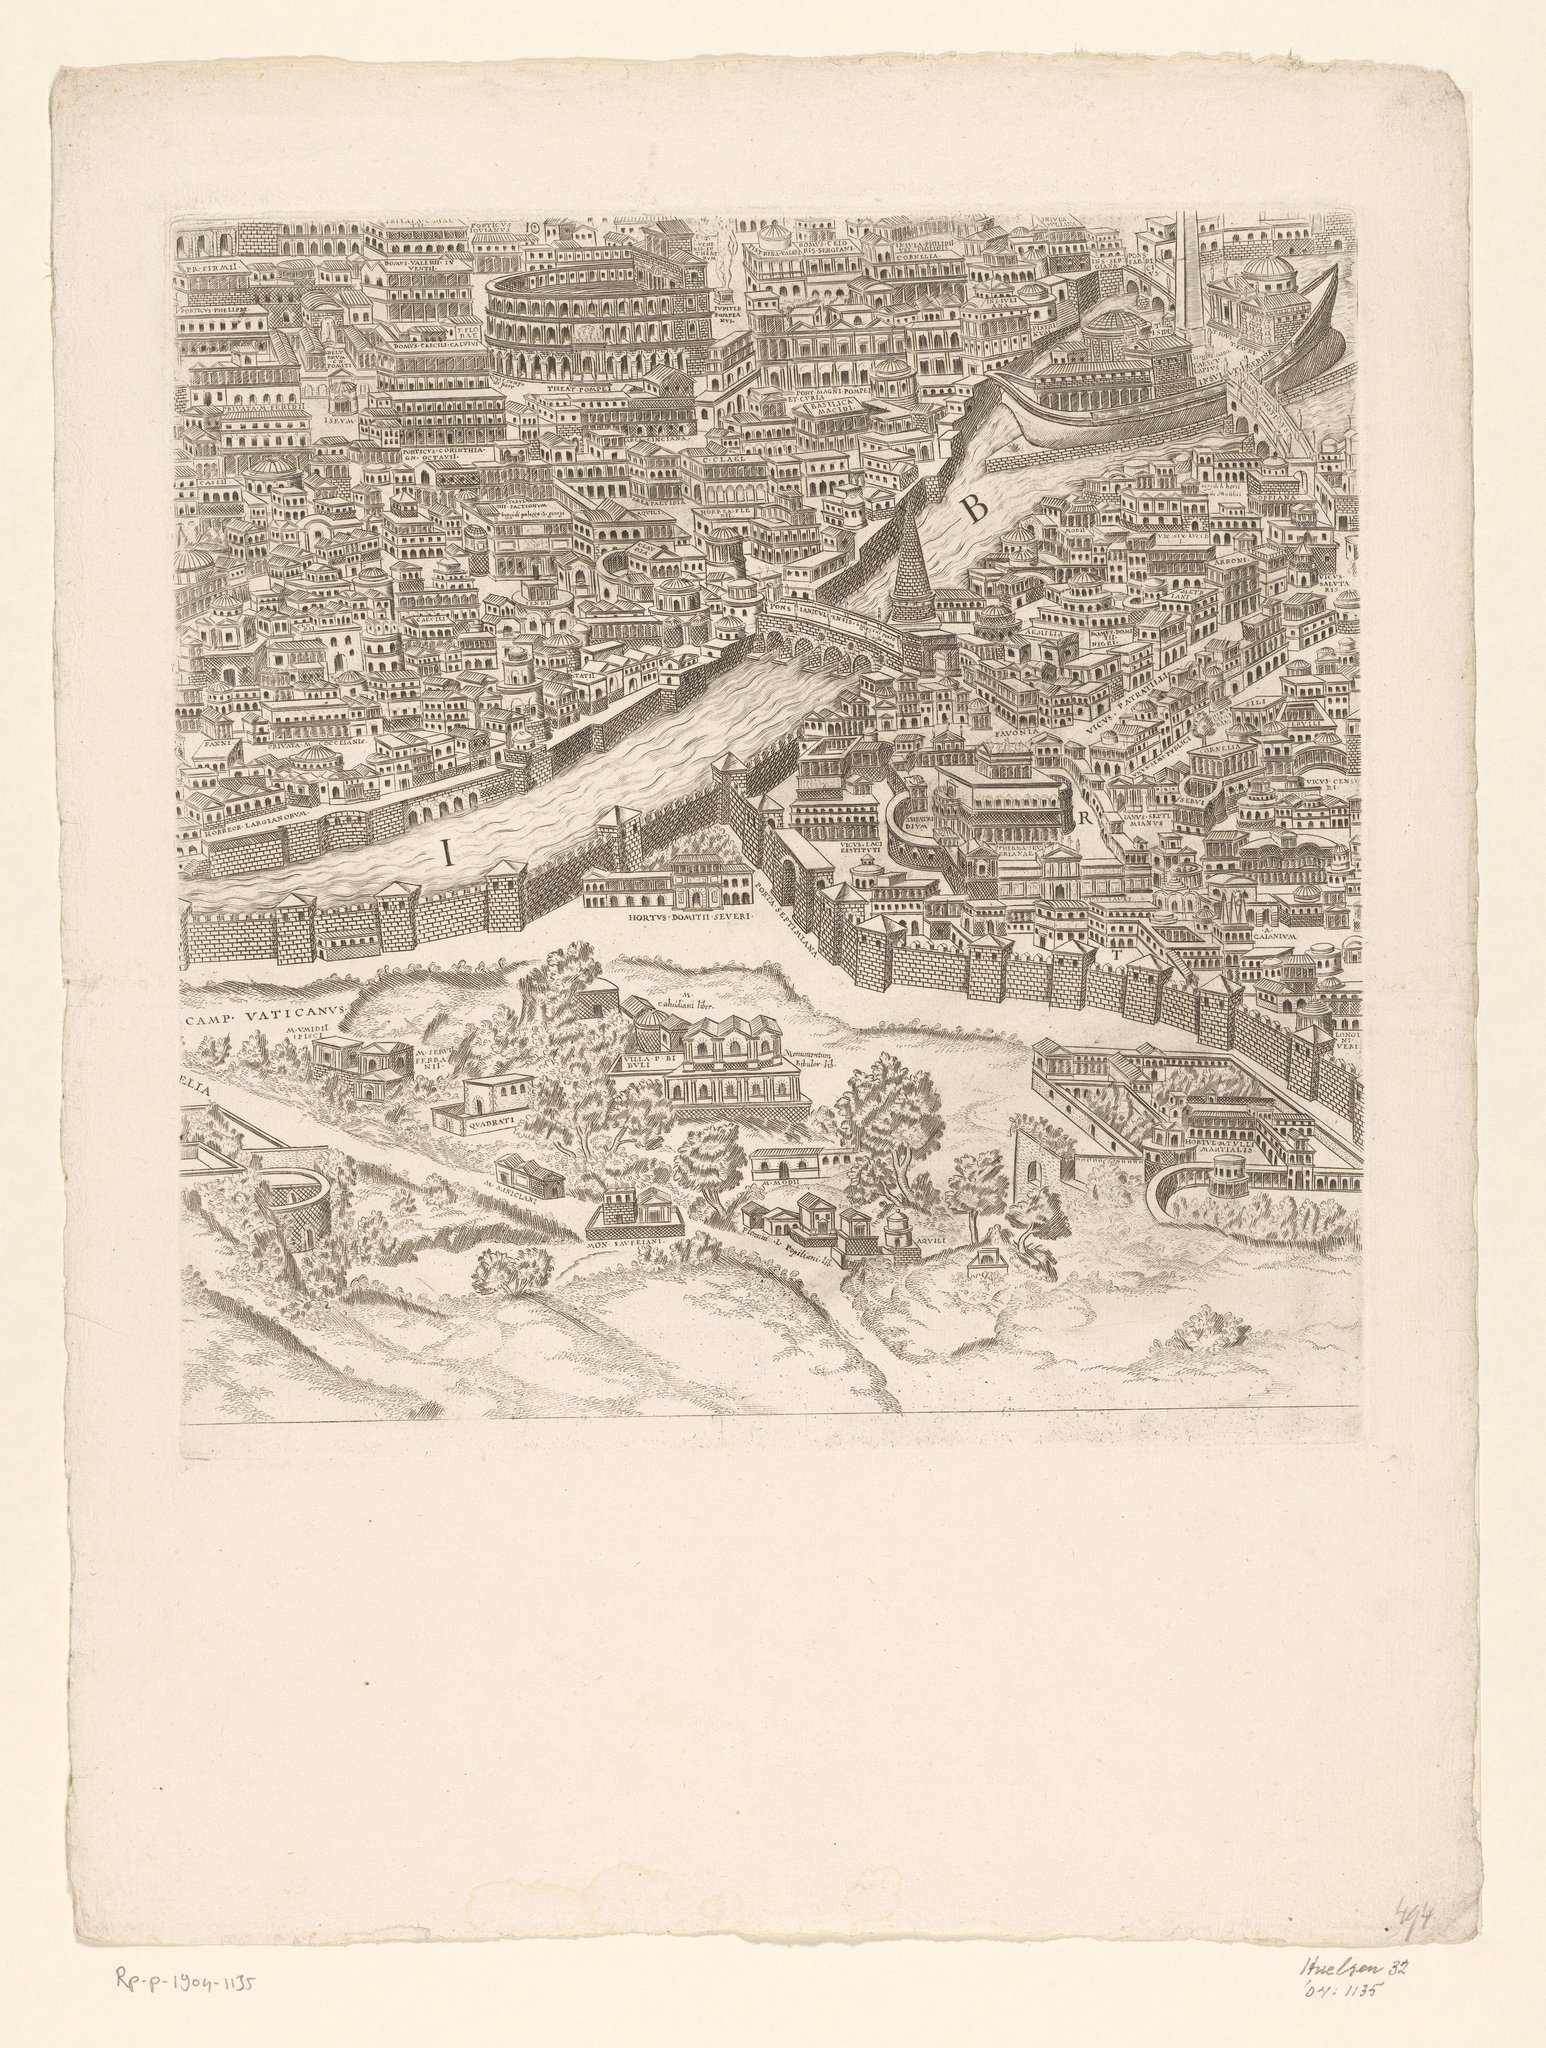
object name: area plan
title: Plattegrond van Rome in de Romeinse tijd (tiende deel)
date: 1773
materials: paper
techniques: engraving, etching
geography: rome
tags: maps of cities, rome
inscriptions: collector's mark: Lugt 2228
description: Tiende deel van een plattegrond van Rome in de Romeinse tijd, in vogelvluchtperspectief, bestaande uit twaalf delen. Linksboven genummerd: 10.